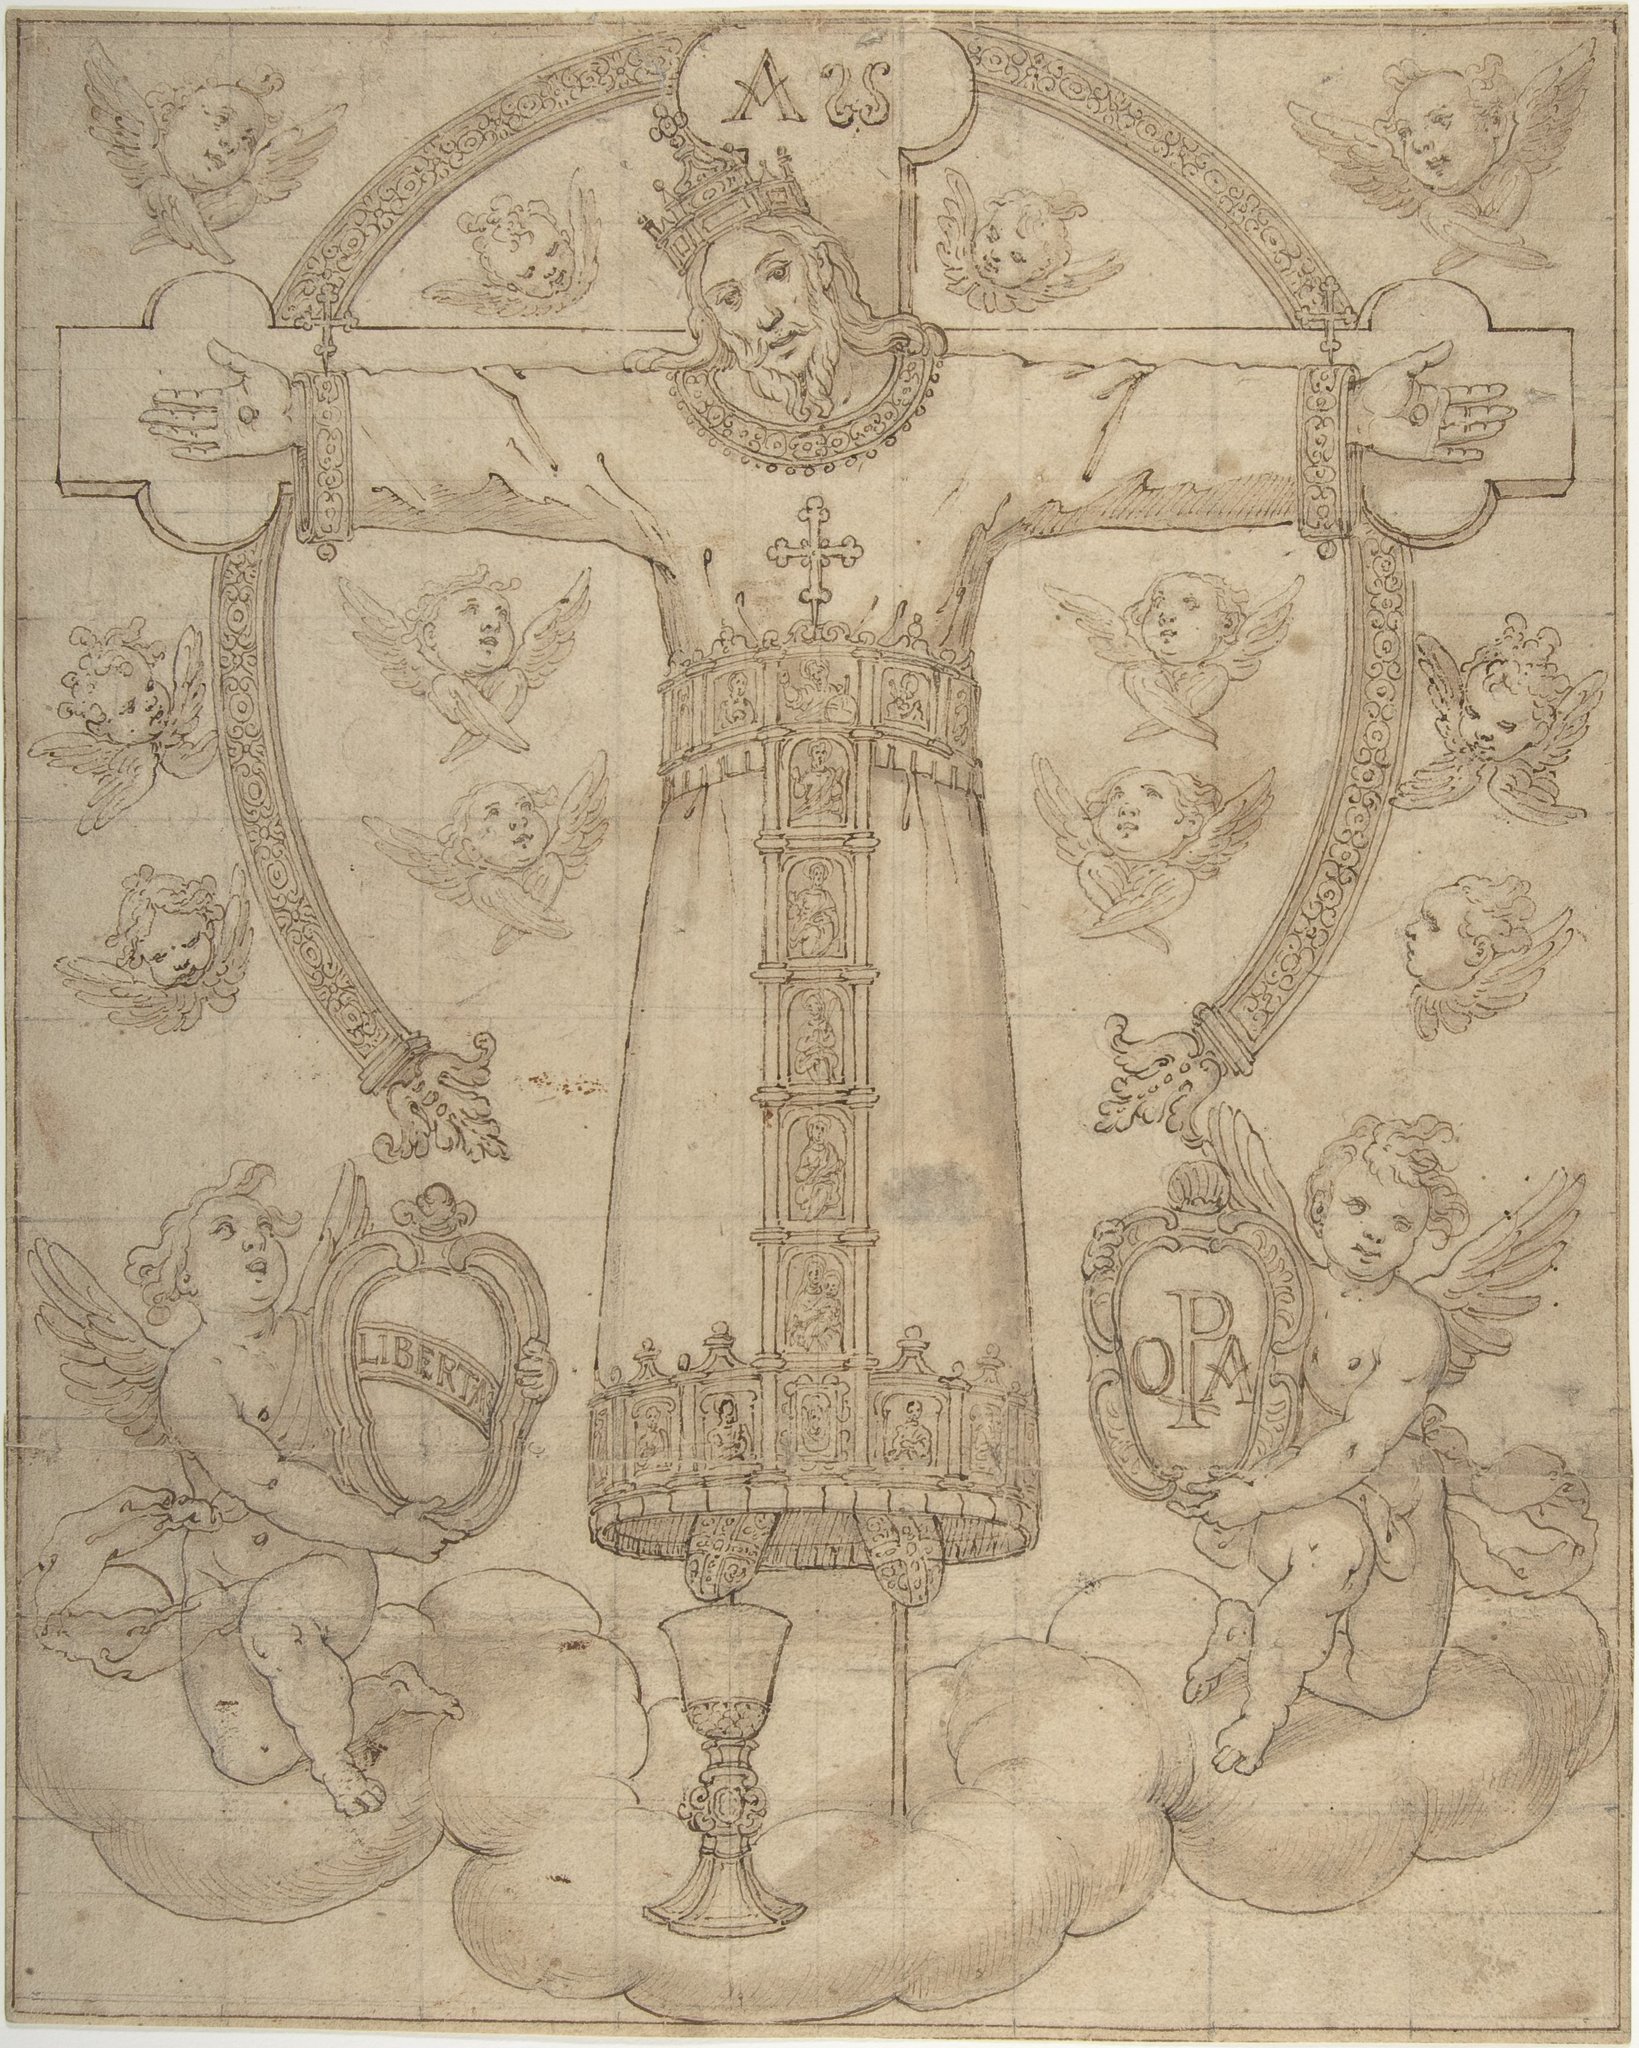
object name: drawing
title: The Volto Santo of Lucca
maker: anonymous, italian, tuscan, 16th century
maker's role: artist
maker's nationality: italian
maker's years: 1500-1600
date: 1501-1600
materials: chalk, ink, paper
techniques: brush, pen, drawing, wash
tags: angels,christ,cross,crucifixion